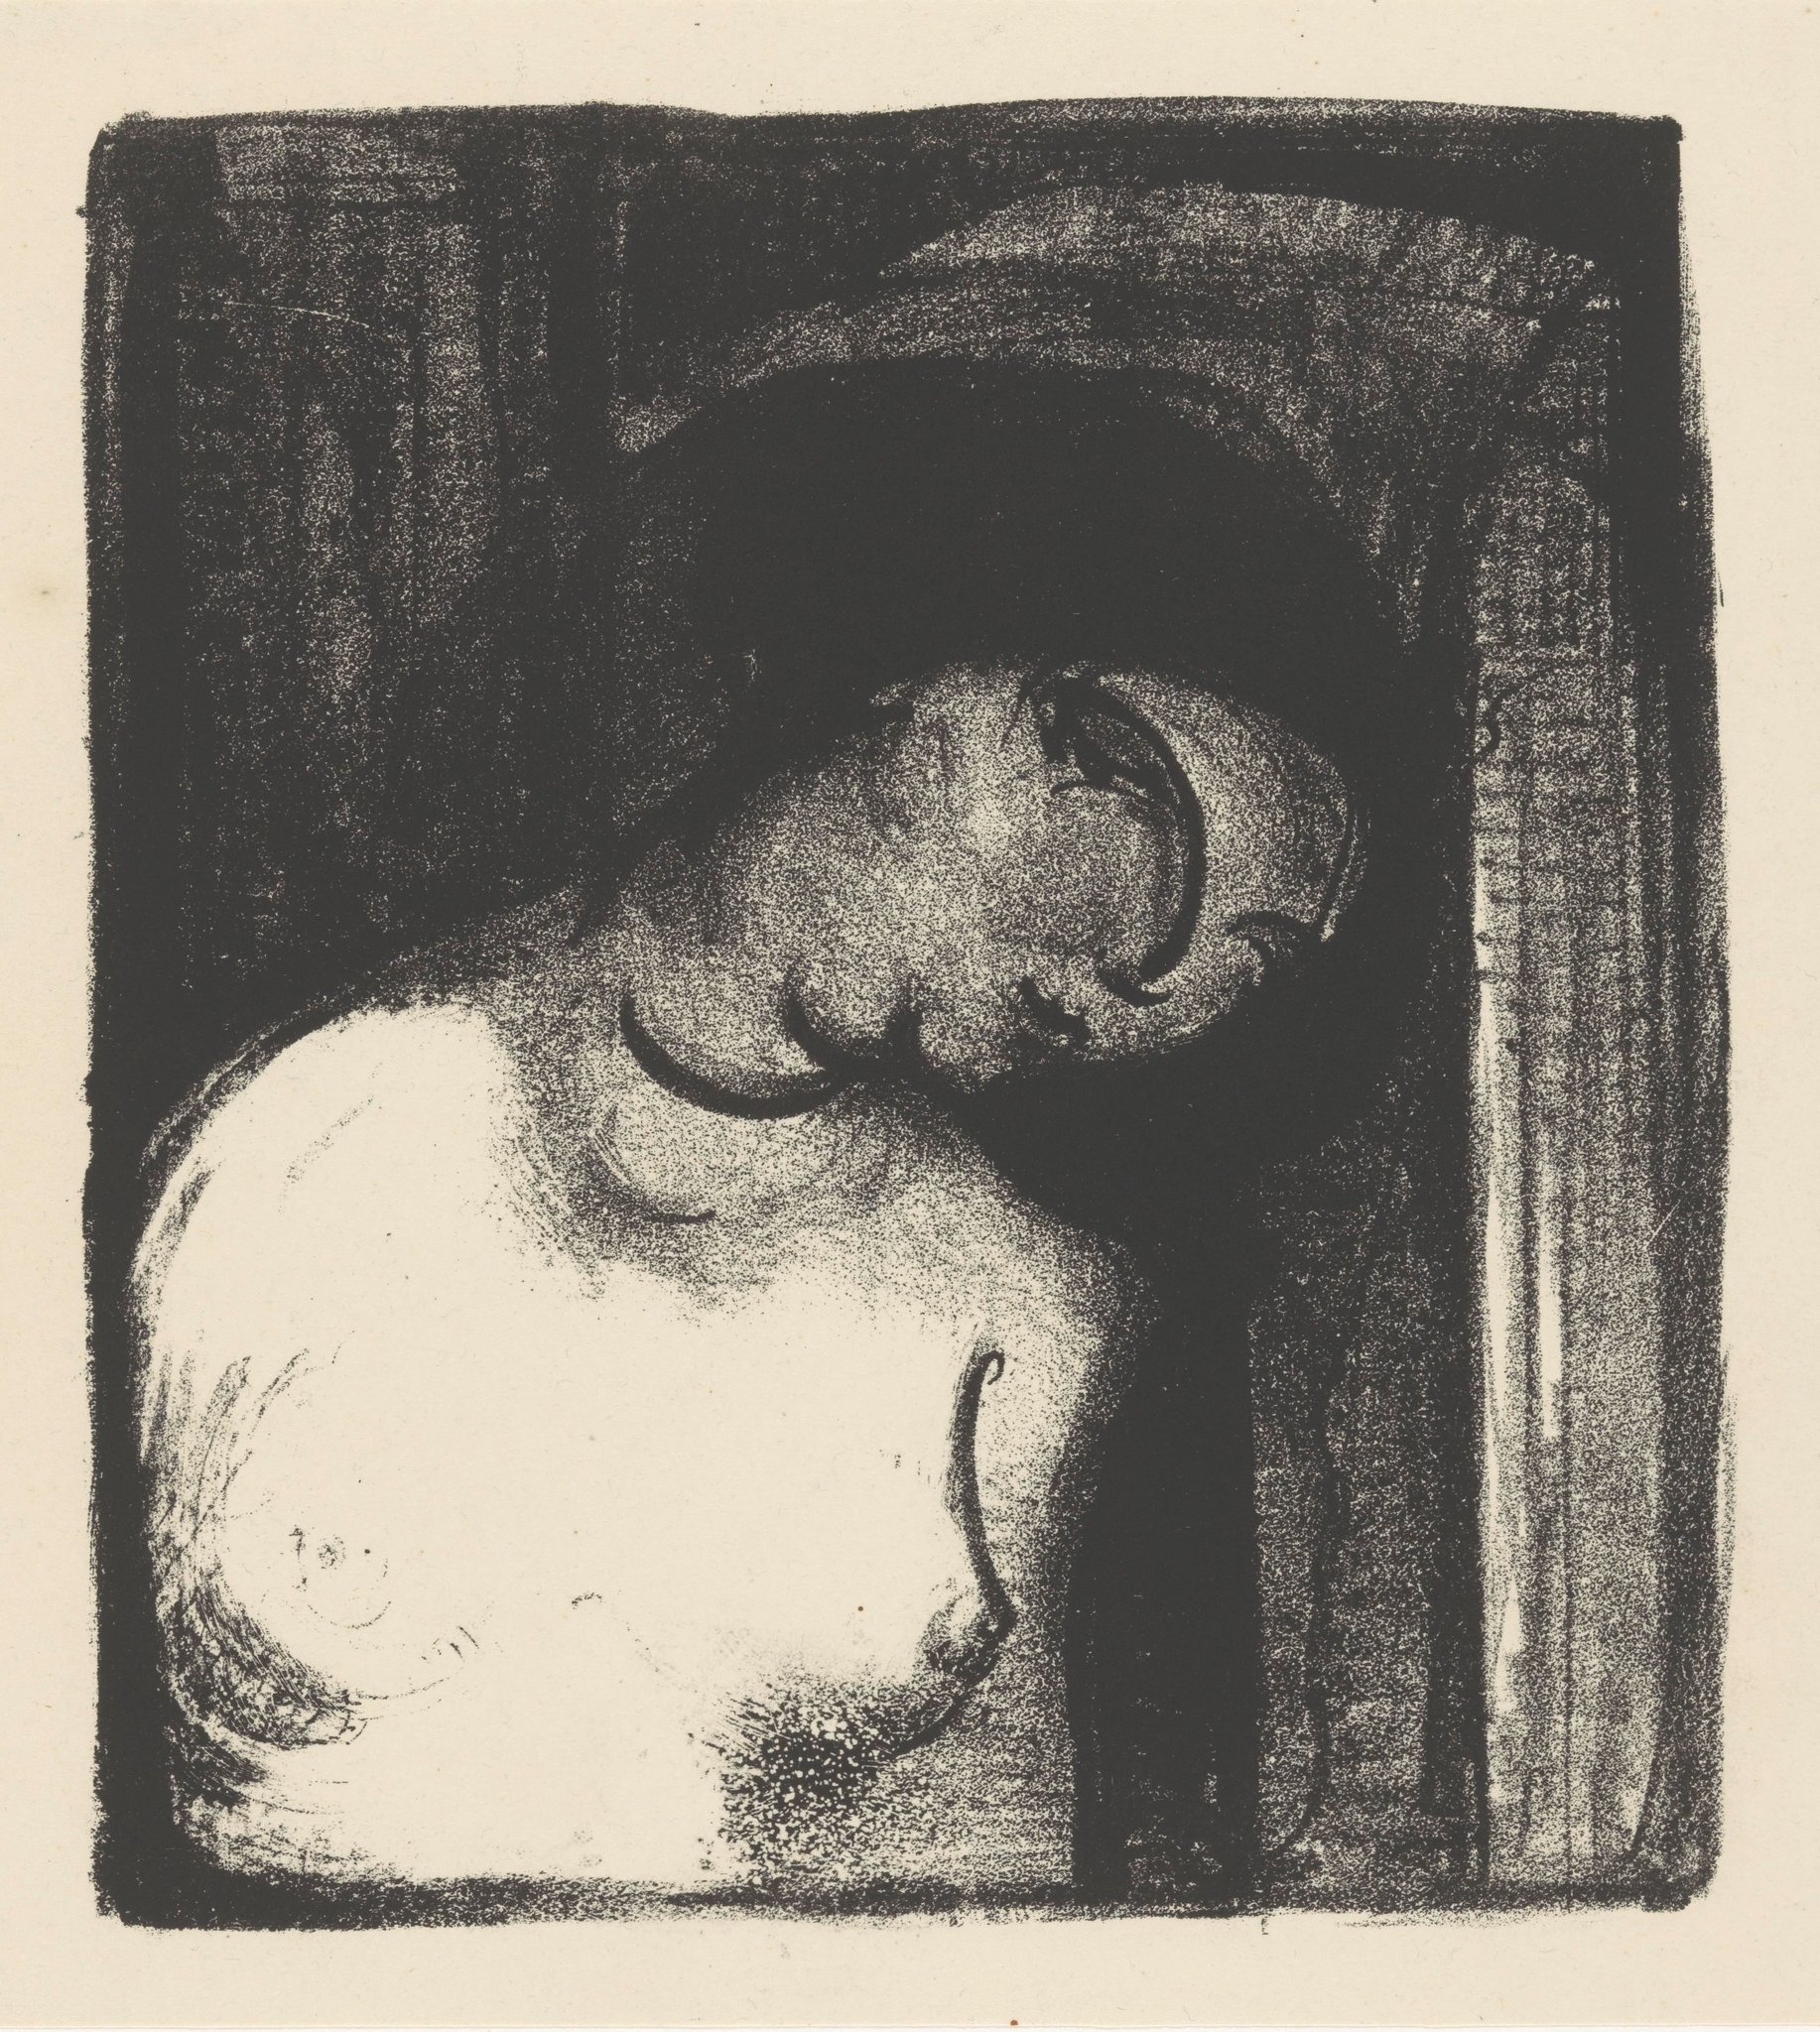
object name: print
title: Naakte vrouw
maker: henri jonas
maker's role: draughtsman, print maker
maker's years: 1878-1944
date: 1888-1944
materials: paper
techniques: lithograph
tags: woman (showing herself) undressed, quasi-nude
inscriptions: collector's mark: Lugt 2228